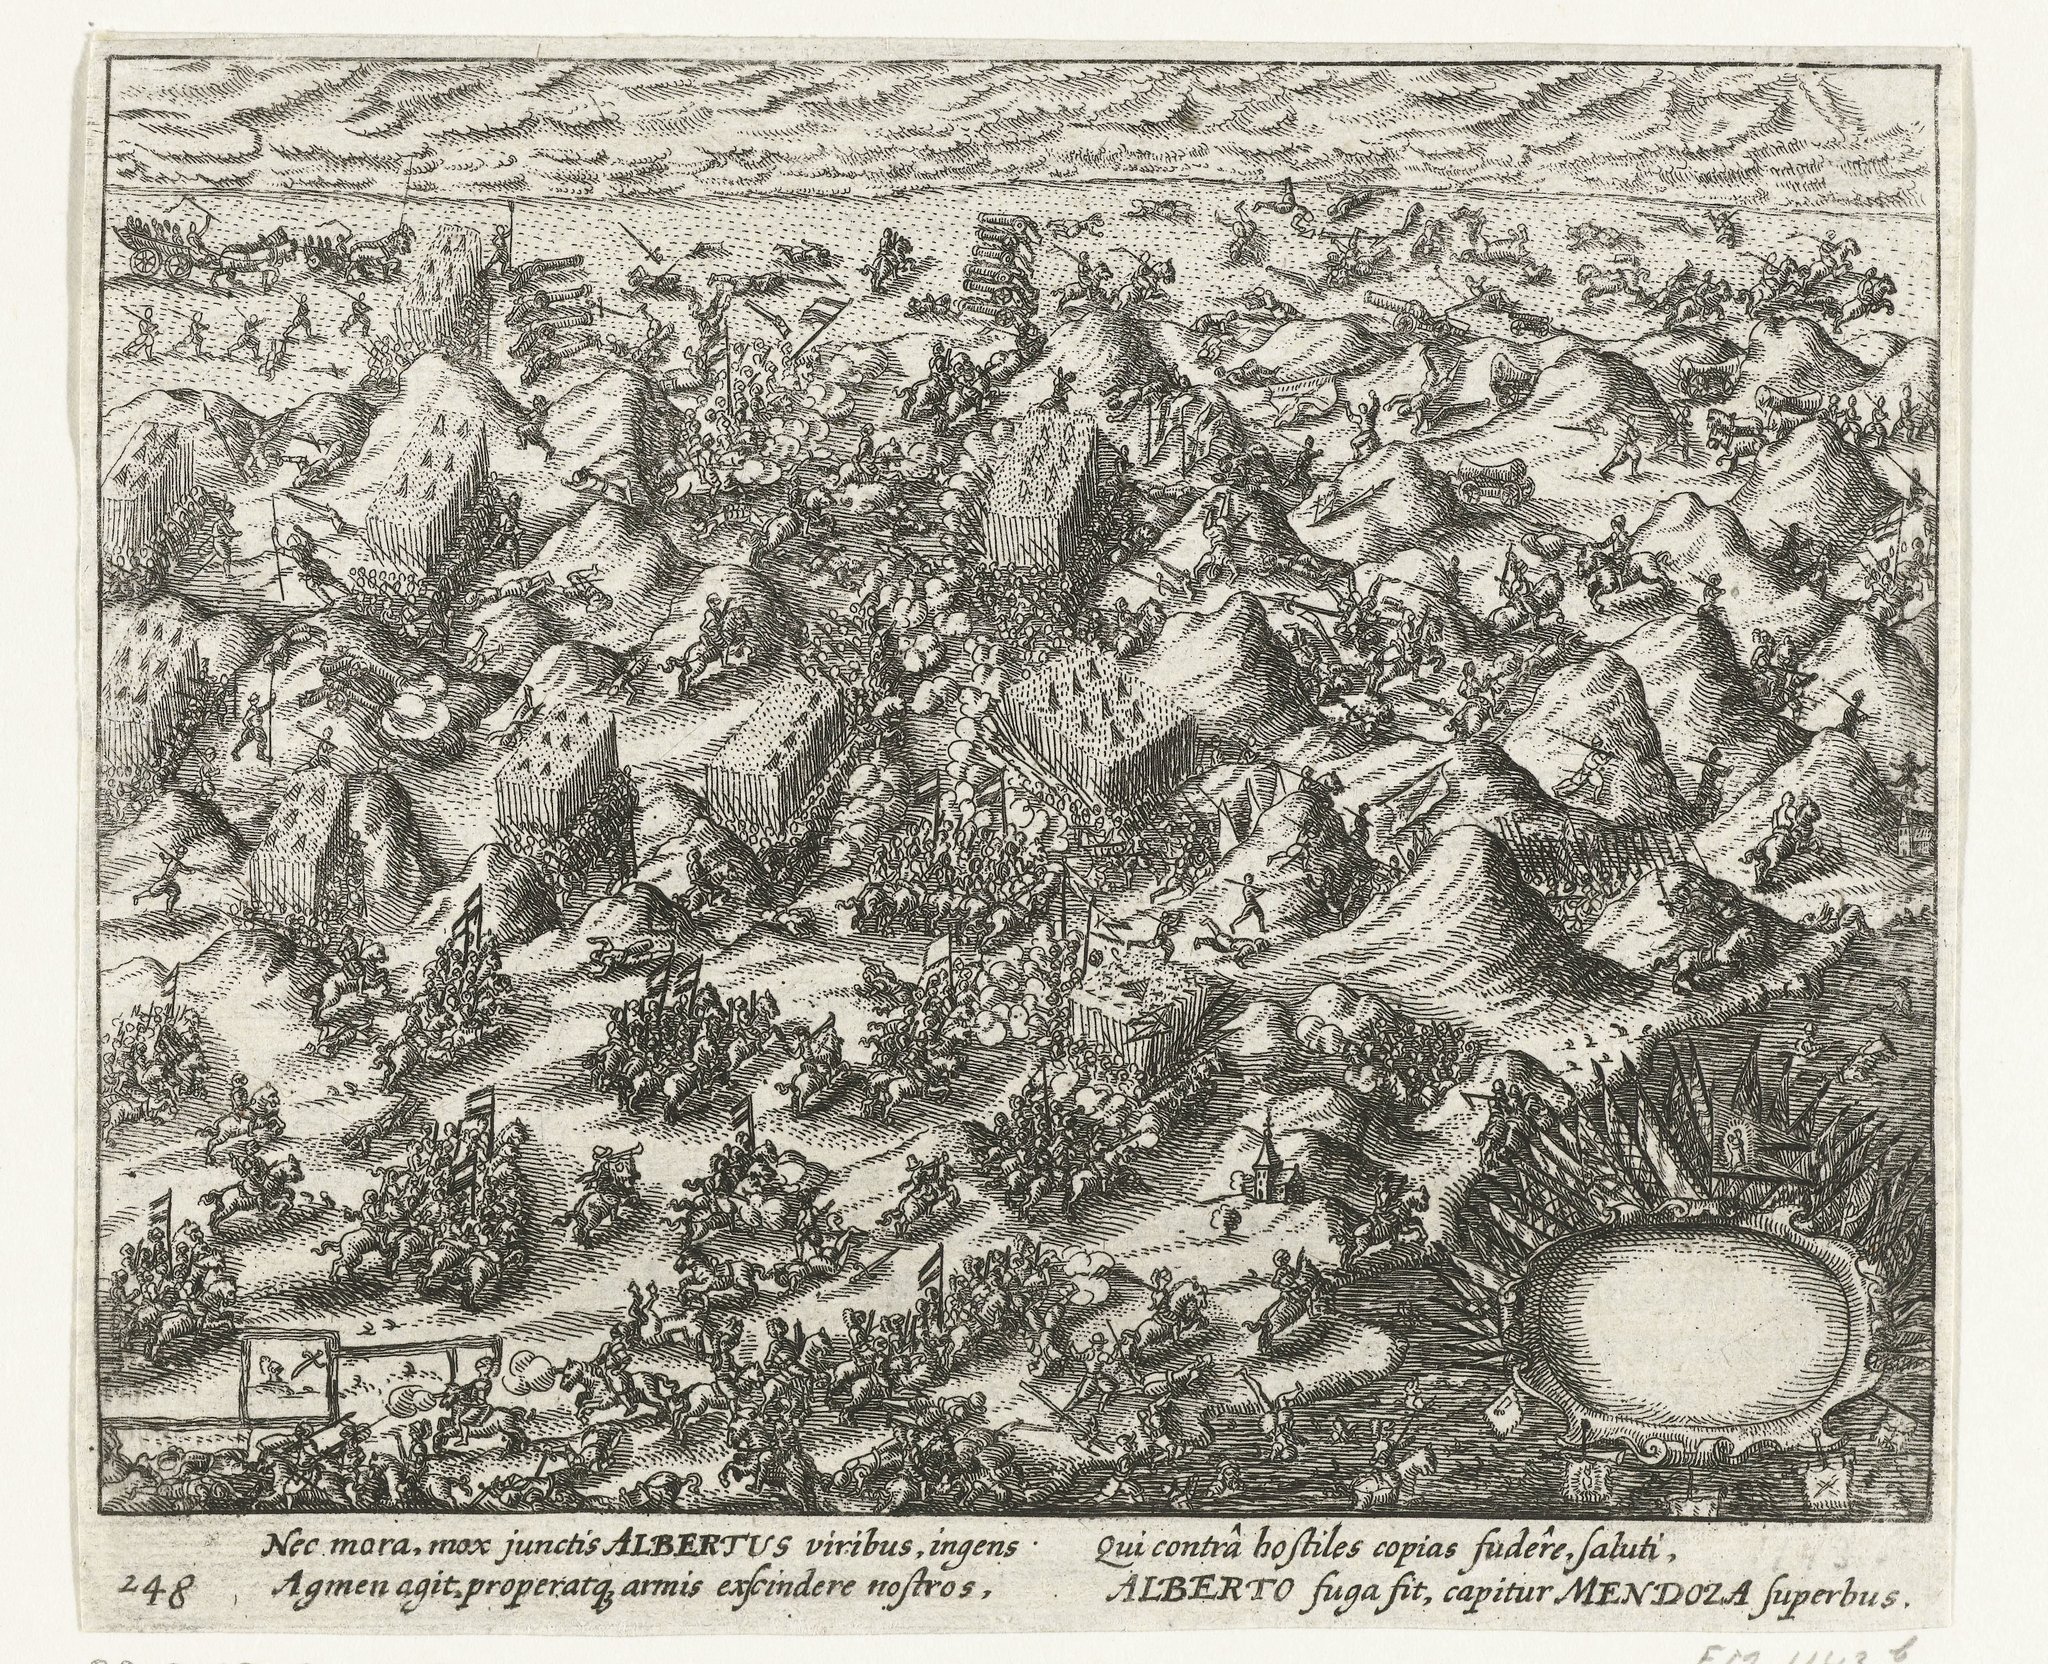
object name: print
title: De slag bij Nieuwpoort, 1600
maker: Anonymous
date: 1613-1615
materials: paper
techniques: etching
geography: northern netherlands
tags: maurice (prince of orange), brussels, albrecht aartshertog van oostenrijk, battle (+ land forces), battle of nieuwpoort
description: De slag bij Nieuwpoort, 2 juli 1600. Gevechten op het strand en in de duinen tussen het Staatse leger onder Maurits en de Spaanse troepen onder Albrecht. Rechtsonder een leeg cartouche versierd met de buitgemaakte Spaanse vaandels. Met onderschrift van 4 regels in het Latijn. Genummerd 248. Bedrukt op verso met tekst in het Latijn.